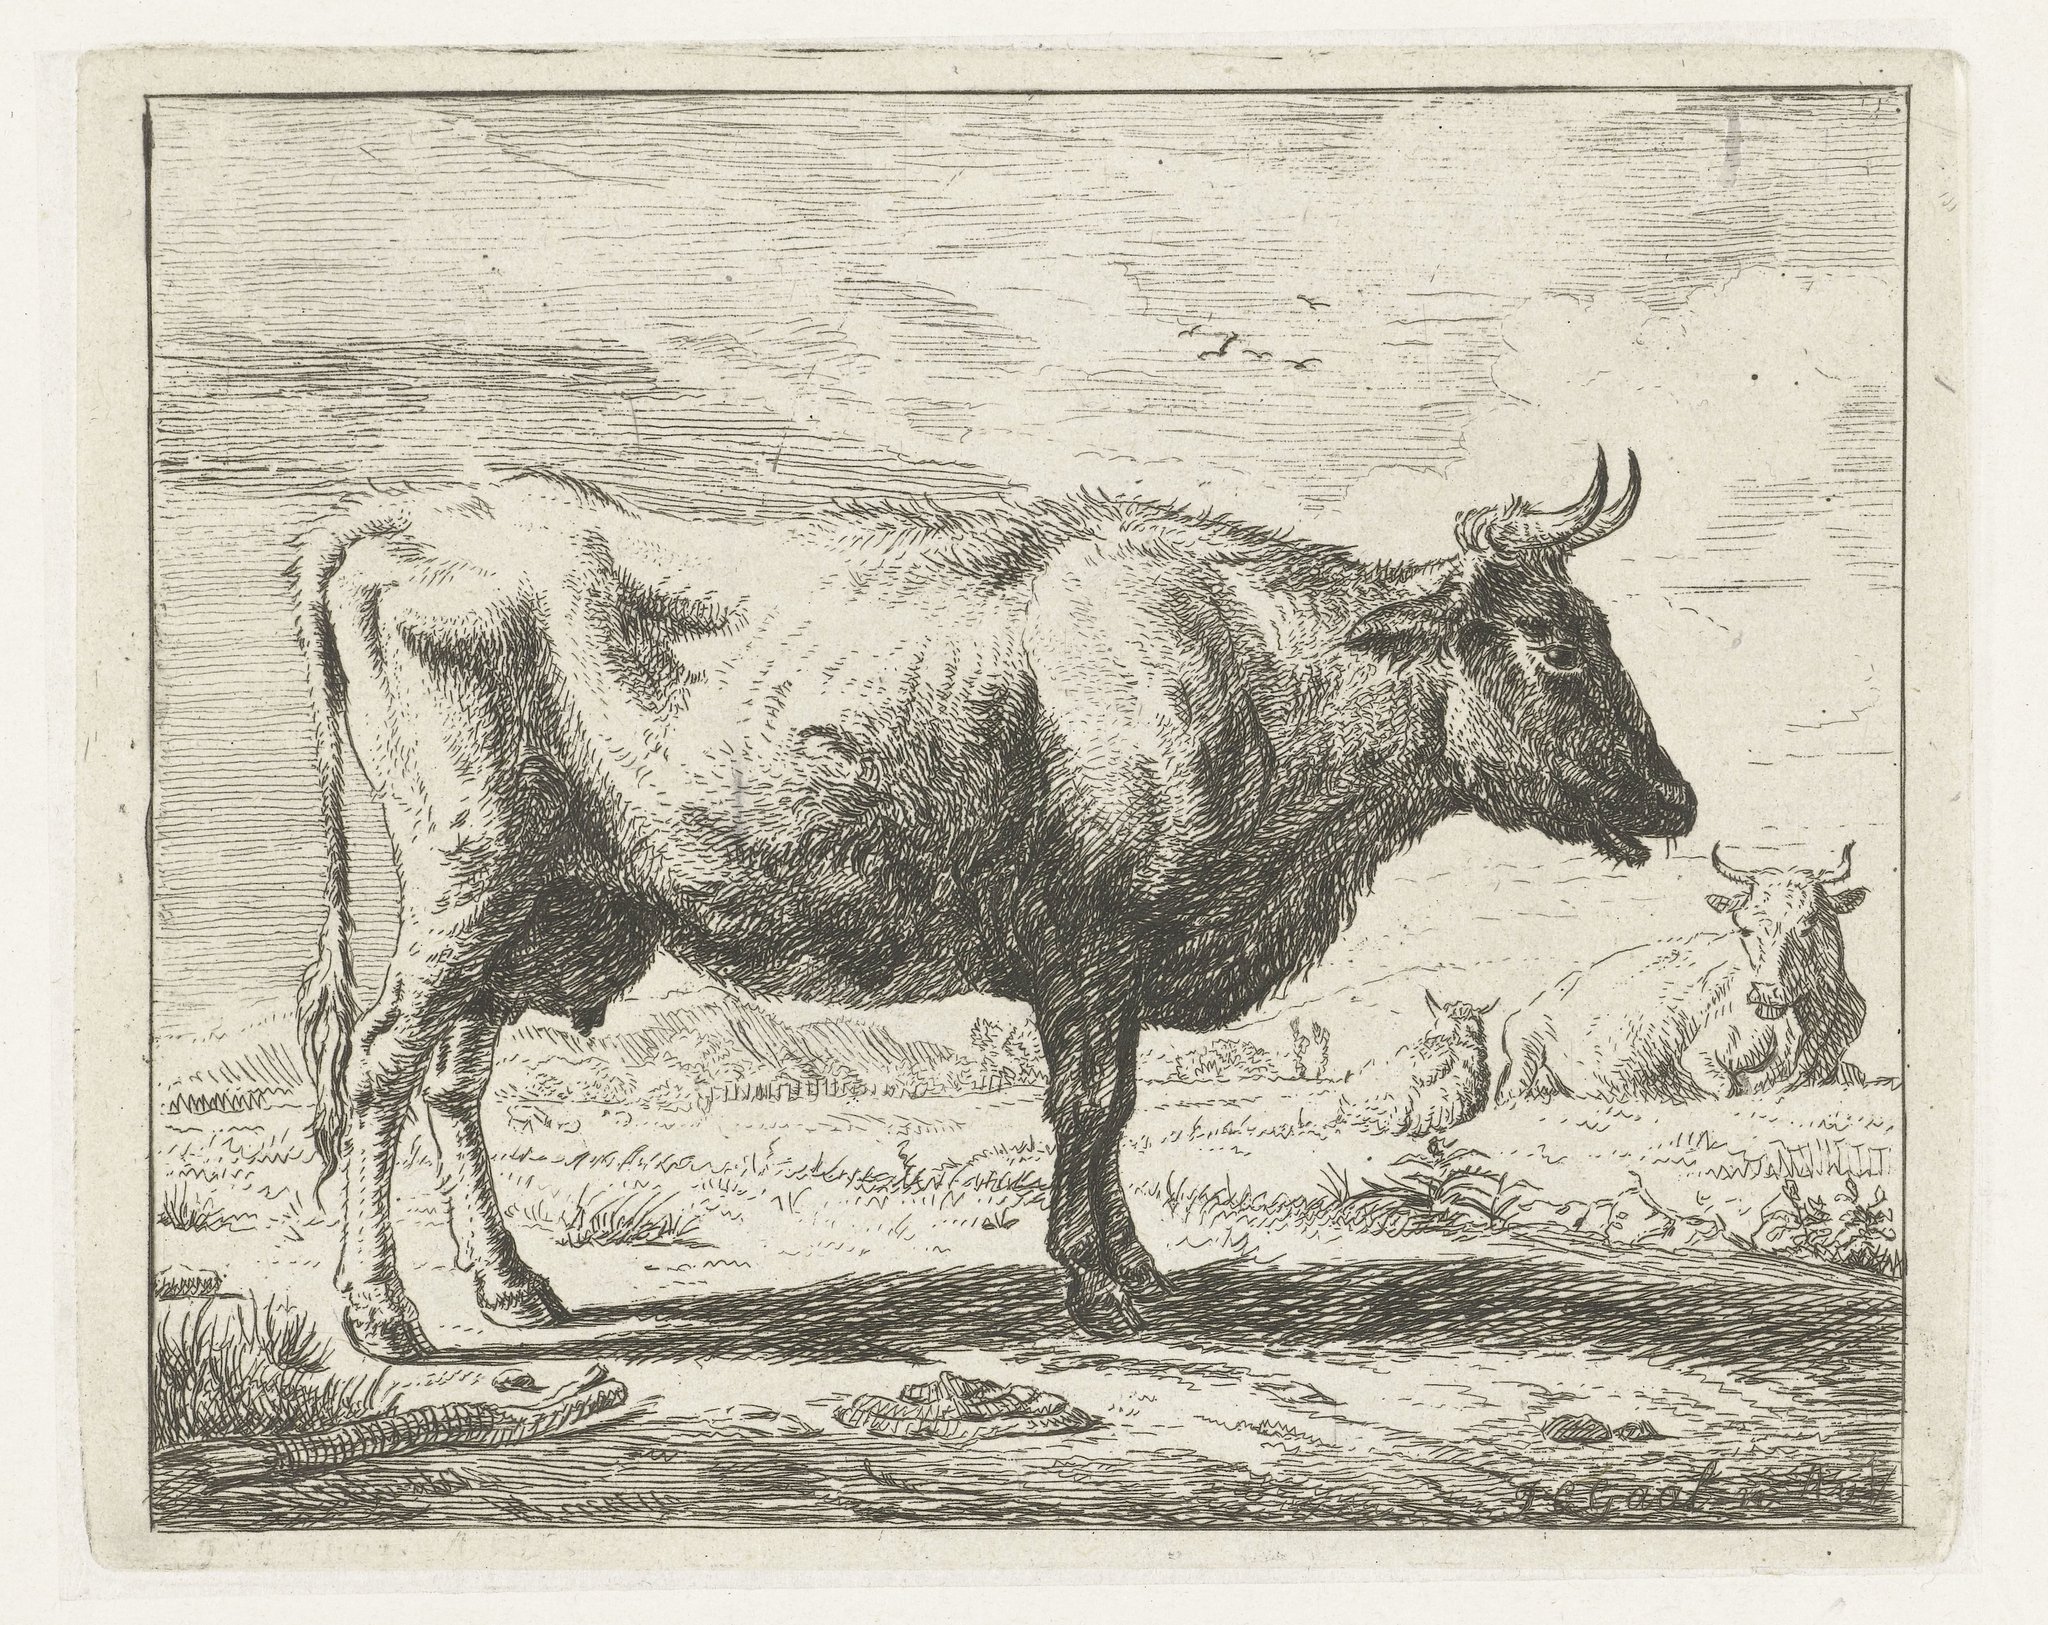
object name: print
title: Staande koe, naar rechts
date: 1850-1860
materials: paper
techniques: etching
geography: netherlands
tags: cow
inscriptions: collector's mark: Lugt 2228